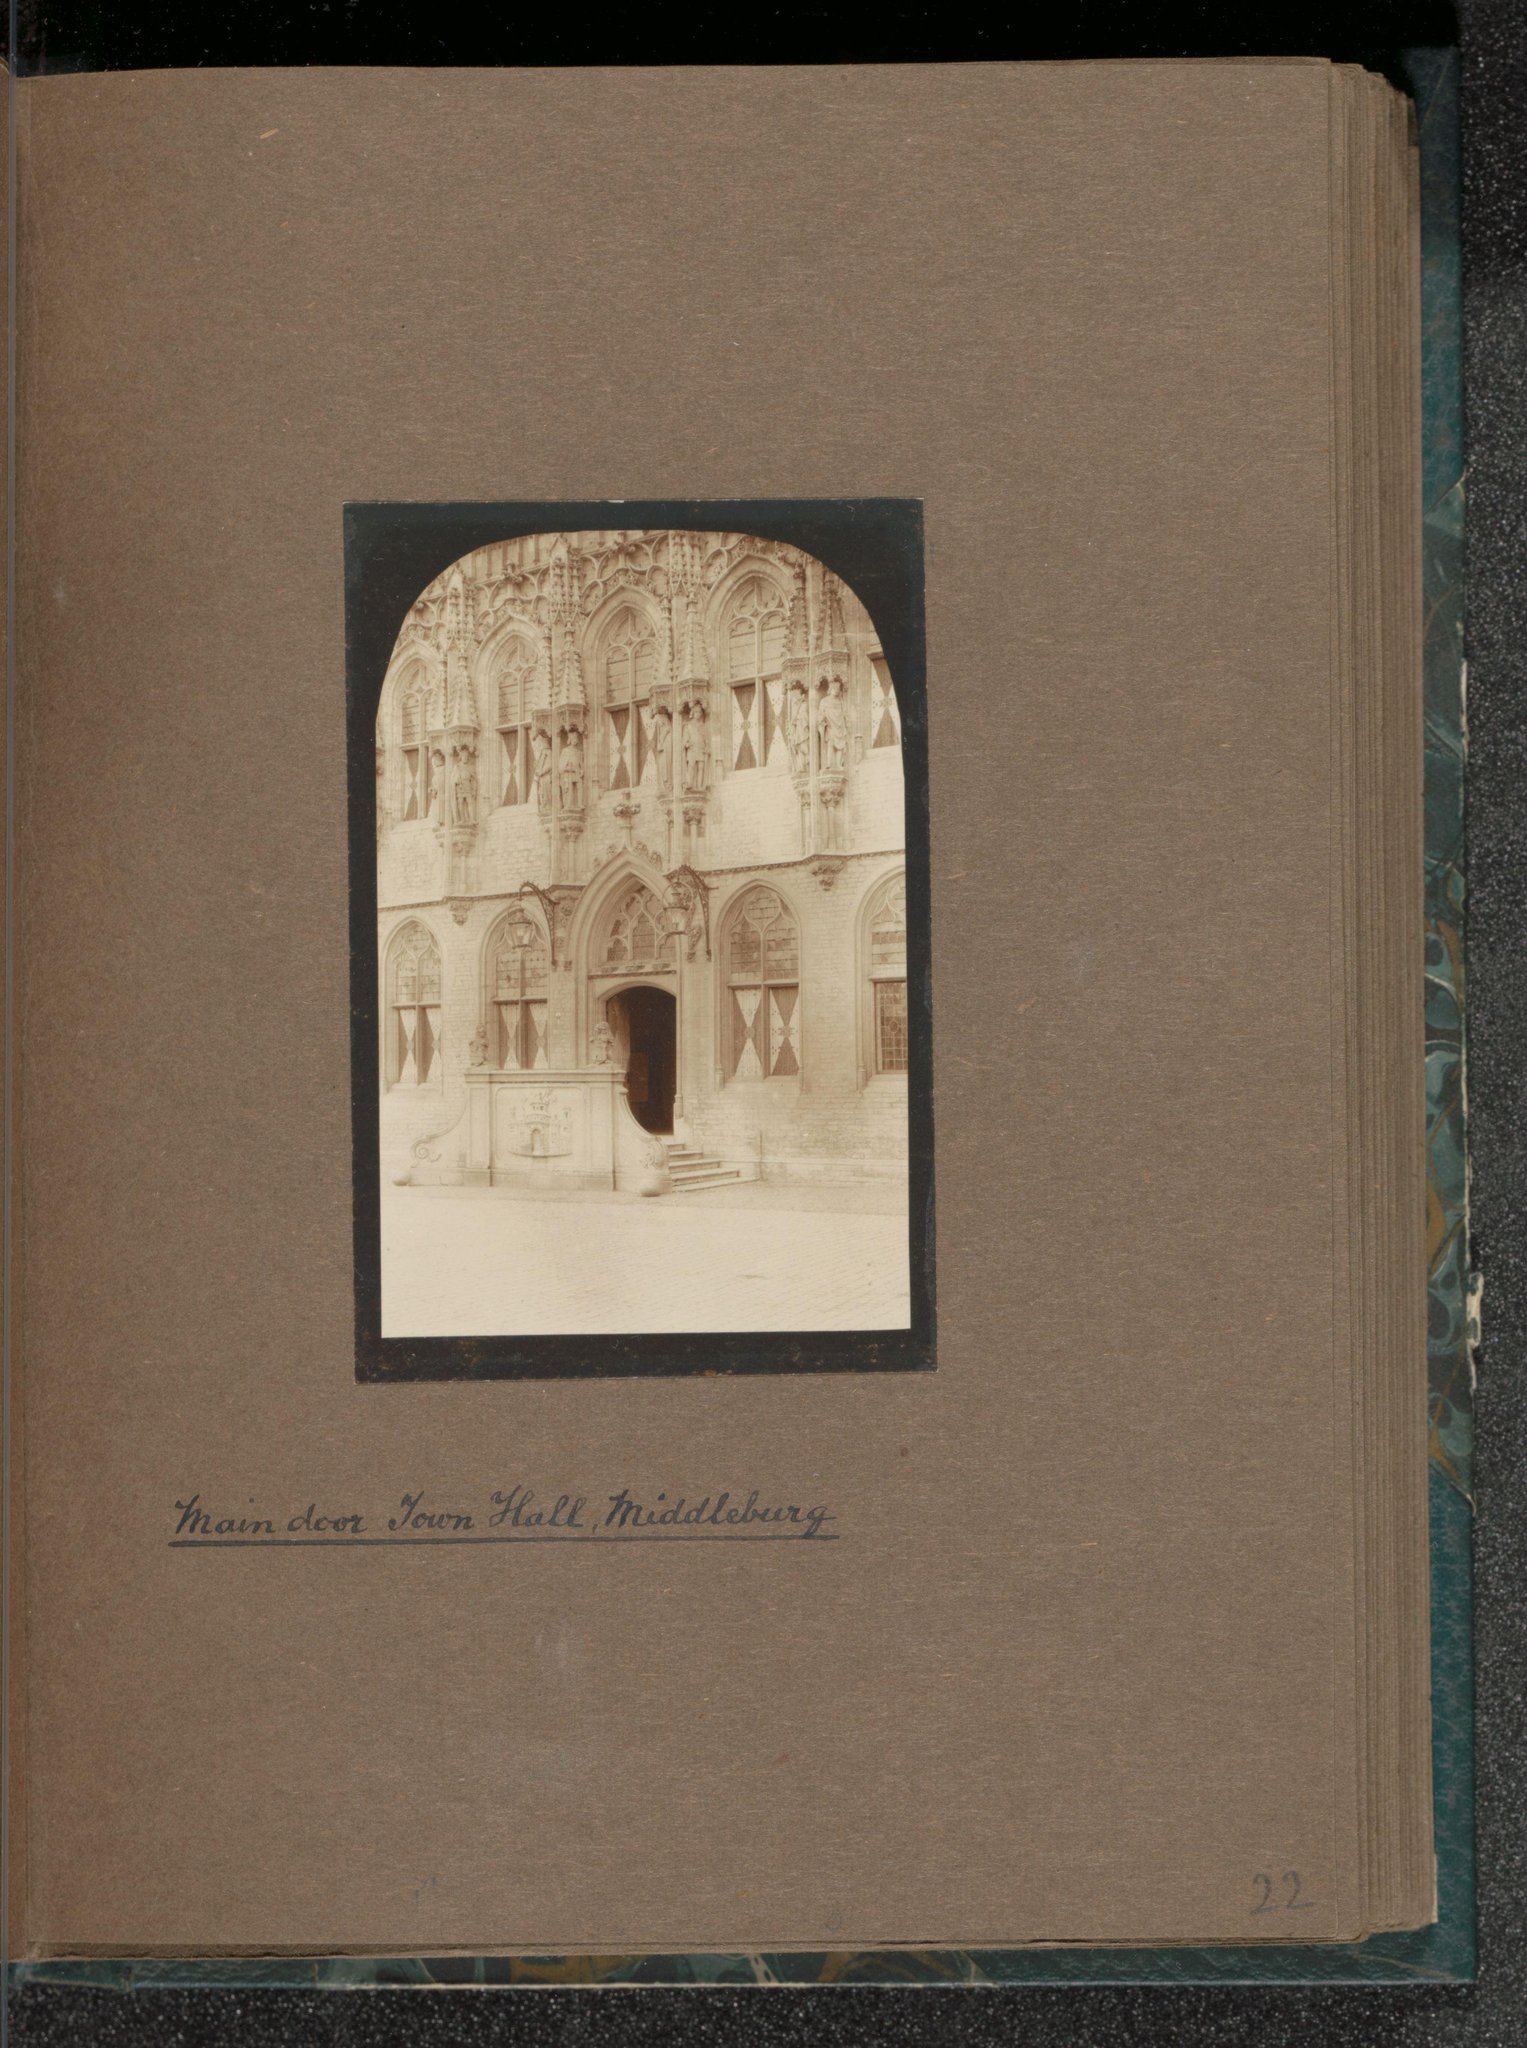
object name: photograph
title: Ingang, ramen, beelden en ornamenten van het stadhuis van Middelburg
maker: Anonymous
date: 1912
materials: photographic support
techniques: gelatin silver print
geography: middelburg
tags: window, gate, entrance, townhall, monument, statue, travelling; tourism, ornament derived from architectural details, middelburg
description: Onderdeel van Fotoalbum van de excursie naar Nederland van de Britse amateurfotografenvereniging P.C.U.K.